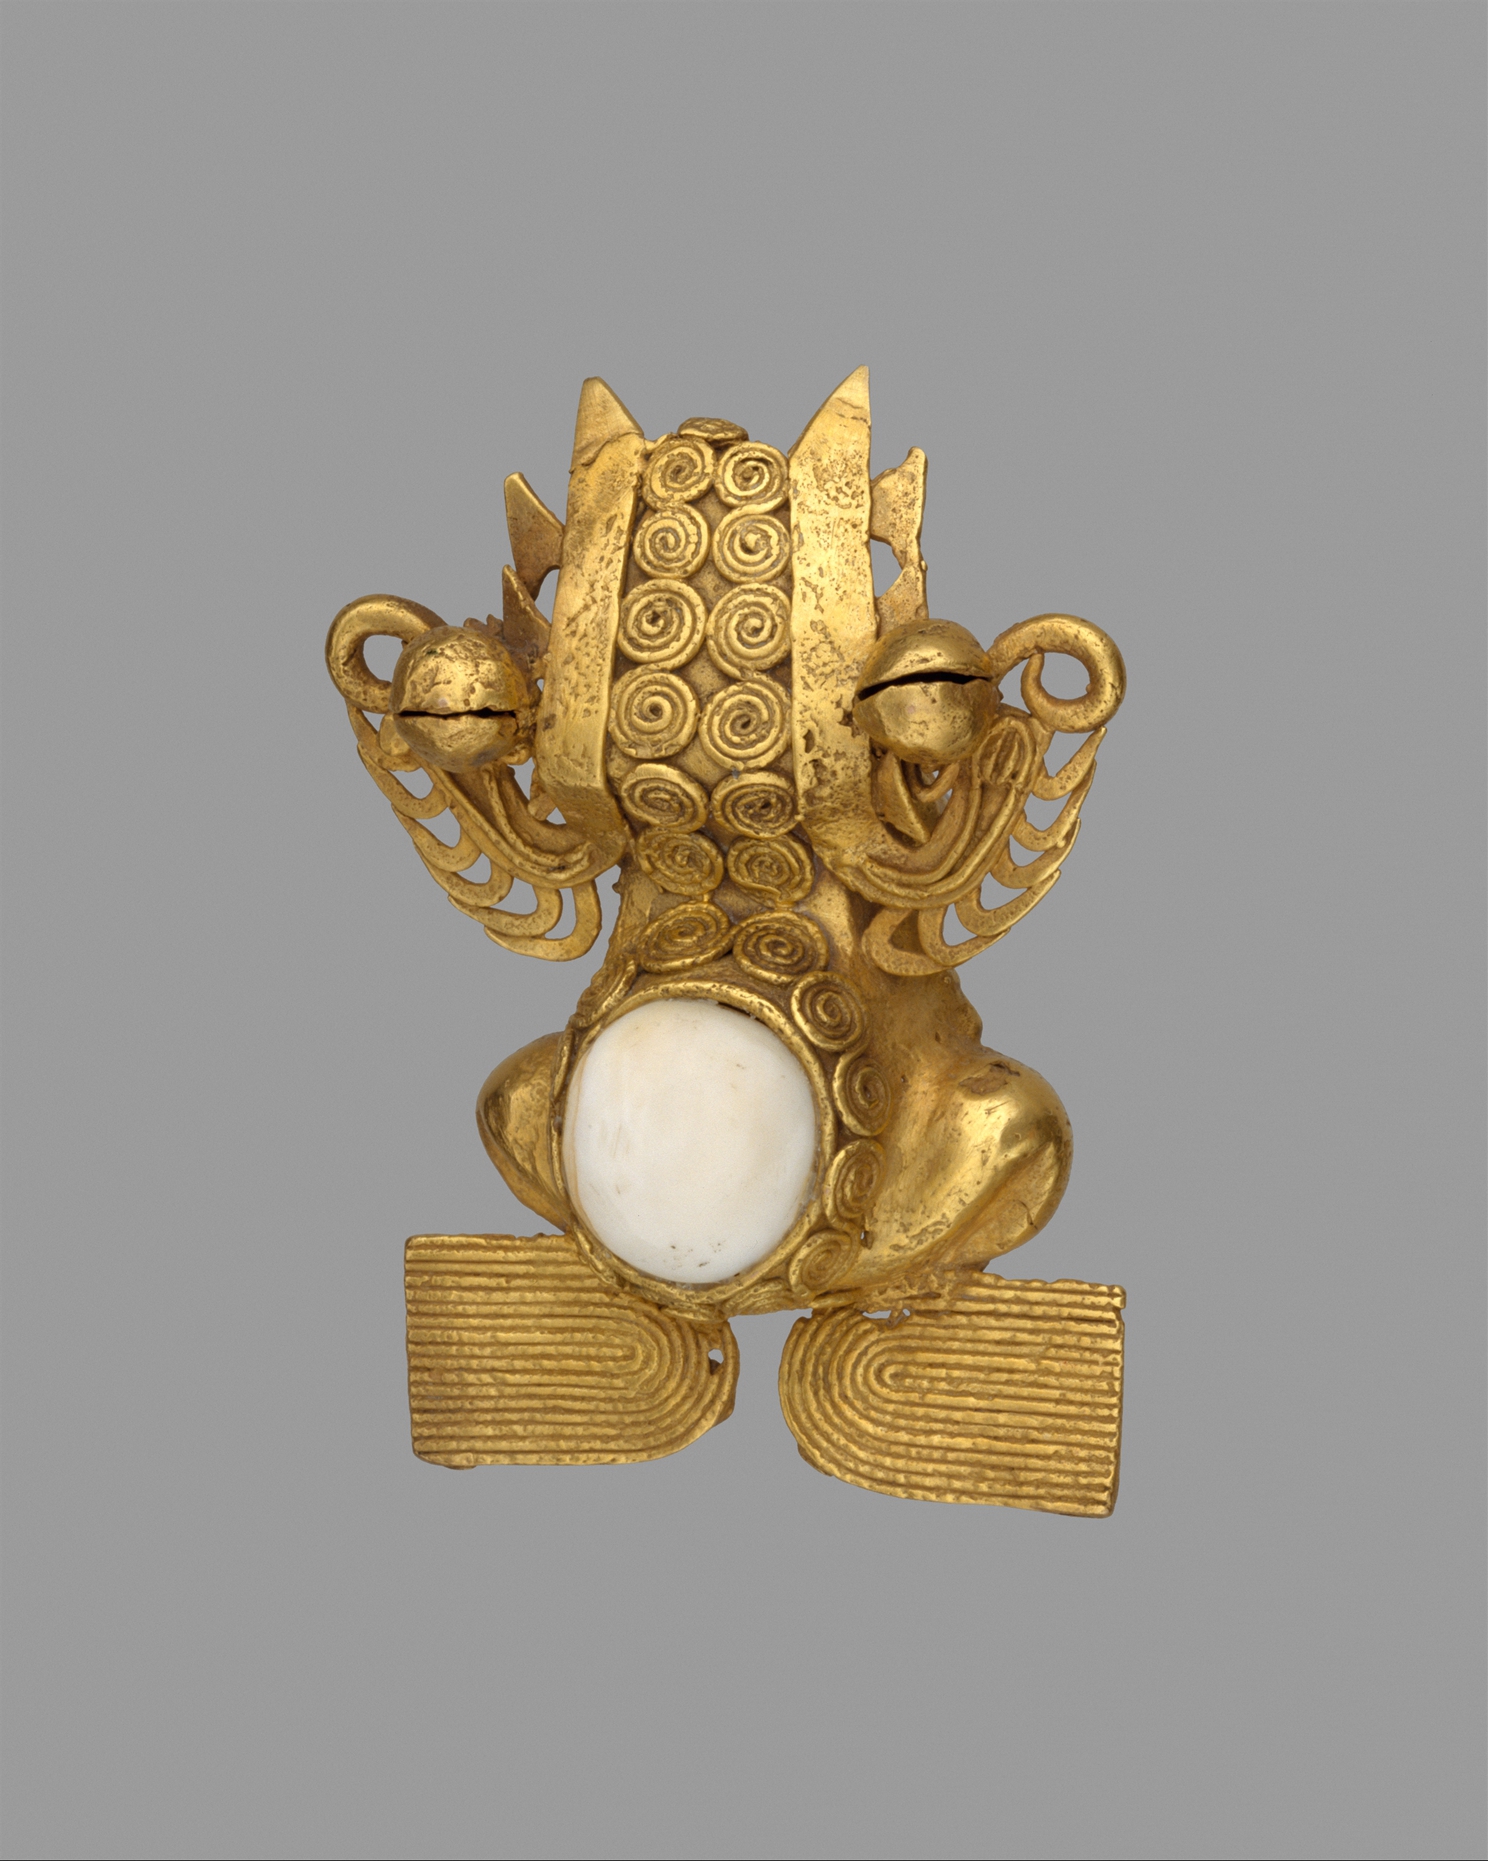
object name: pendant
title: Frog Pendant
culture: coclé, parita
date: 1101-1400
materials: gold, pigment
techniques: inlay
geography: panama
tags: frogs